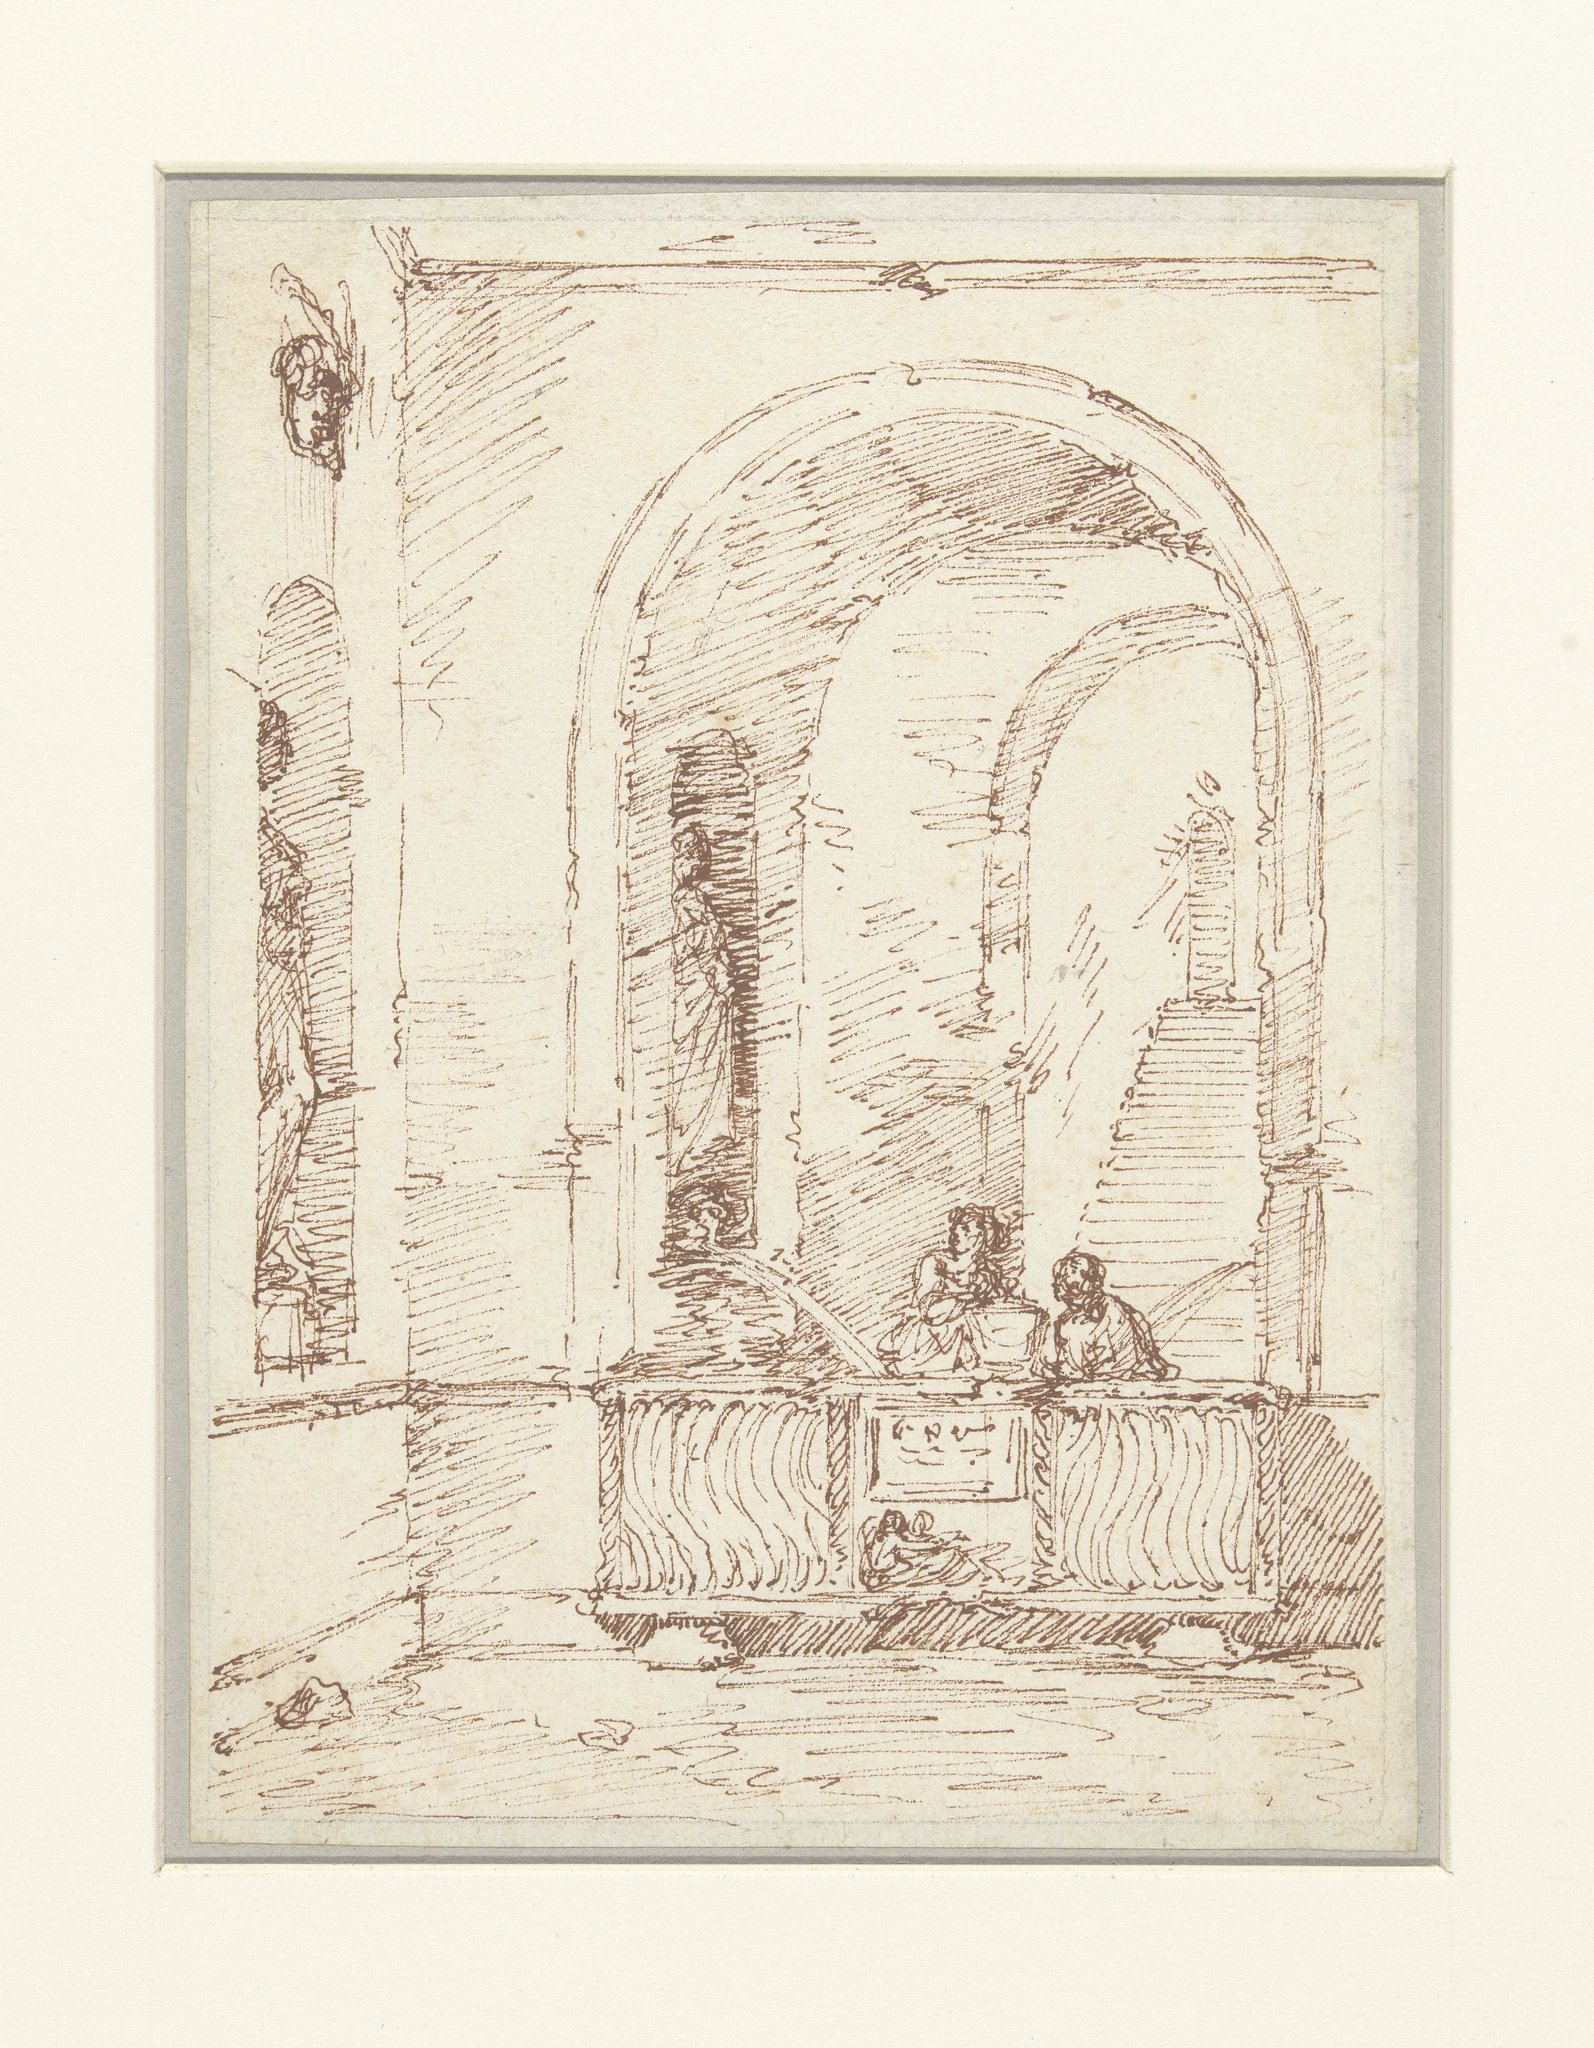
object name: drawing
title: Twee vrouwen bij een sarcofaag die als fontein dient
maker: victor jean nicolle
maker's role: draughtsman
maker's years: 1754-1826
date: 1787-1811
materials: chalk, ink, paper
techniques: pen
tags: utilitarian, public pump or water fountain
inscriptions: collector's mark, verso, lower centre: Lugt 2228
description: Twee vrouwen bij een sarcofaag die als fontein dient; links beelden in nissen, op de achtergrond een trap.